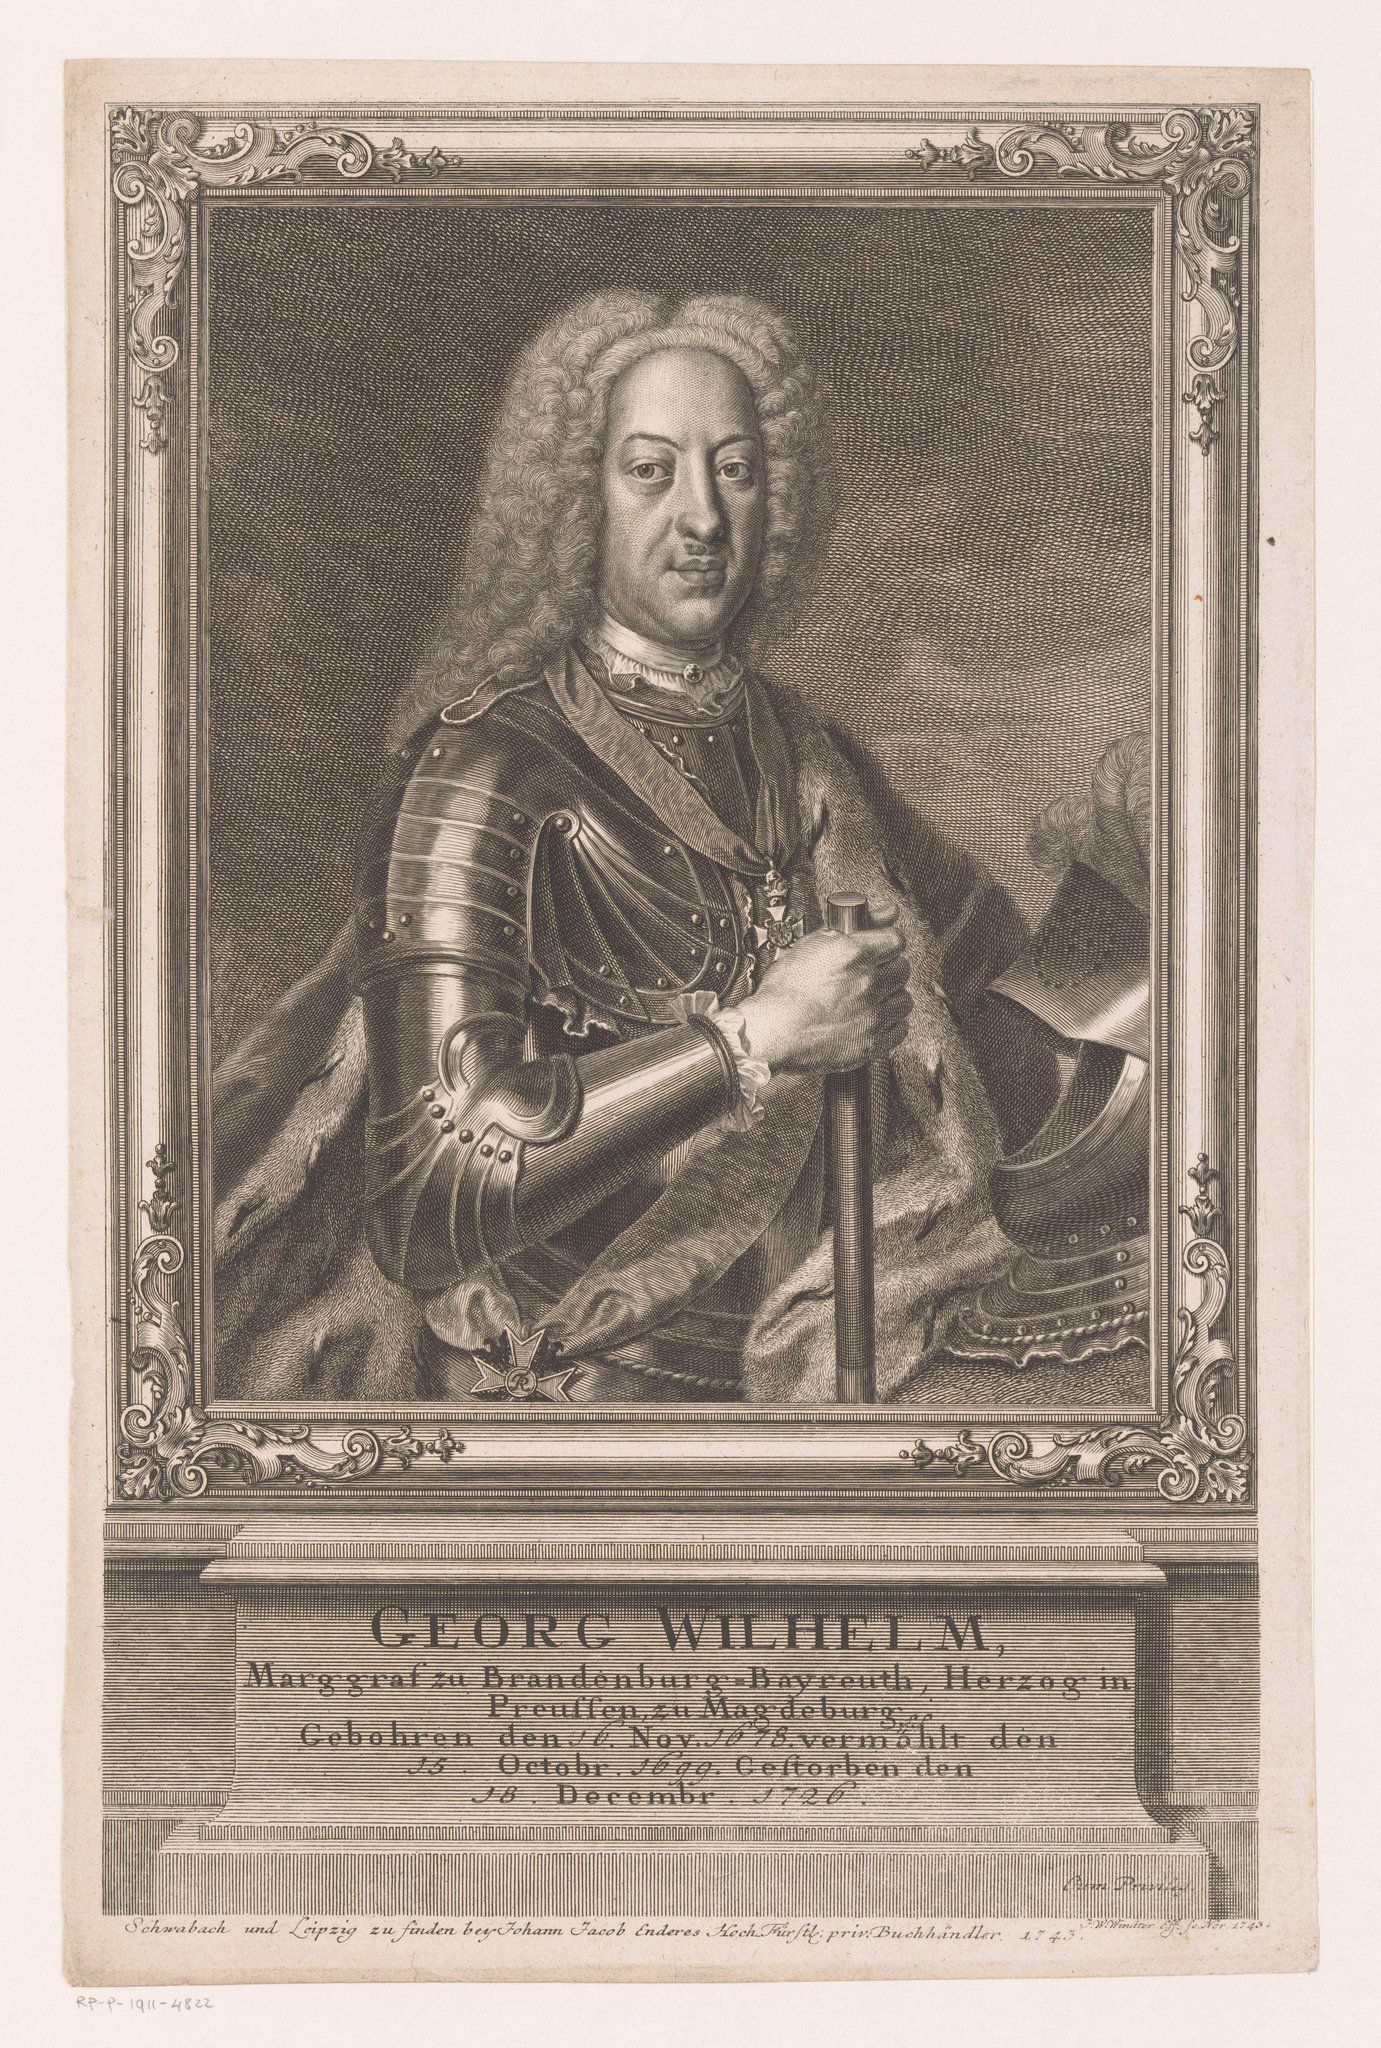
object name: print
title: Portret van George Willem van Brandenburg-Bayreuth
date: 1743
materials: paper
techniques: engraving, etching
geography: nuremberg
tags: historical persons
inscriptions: collector's mark: Lugt 2228